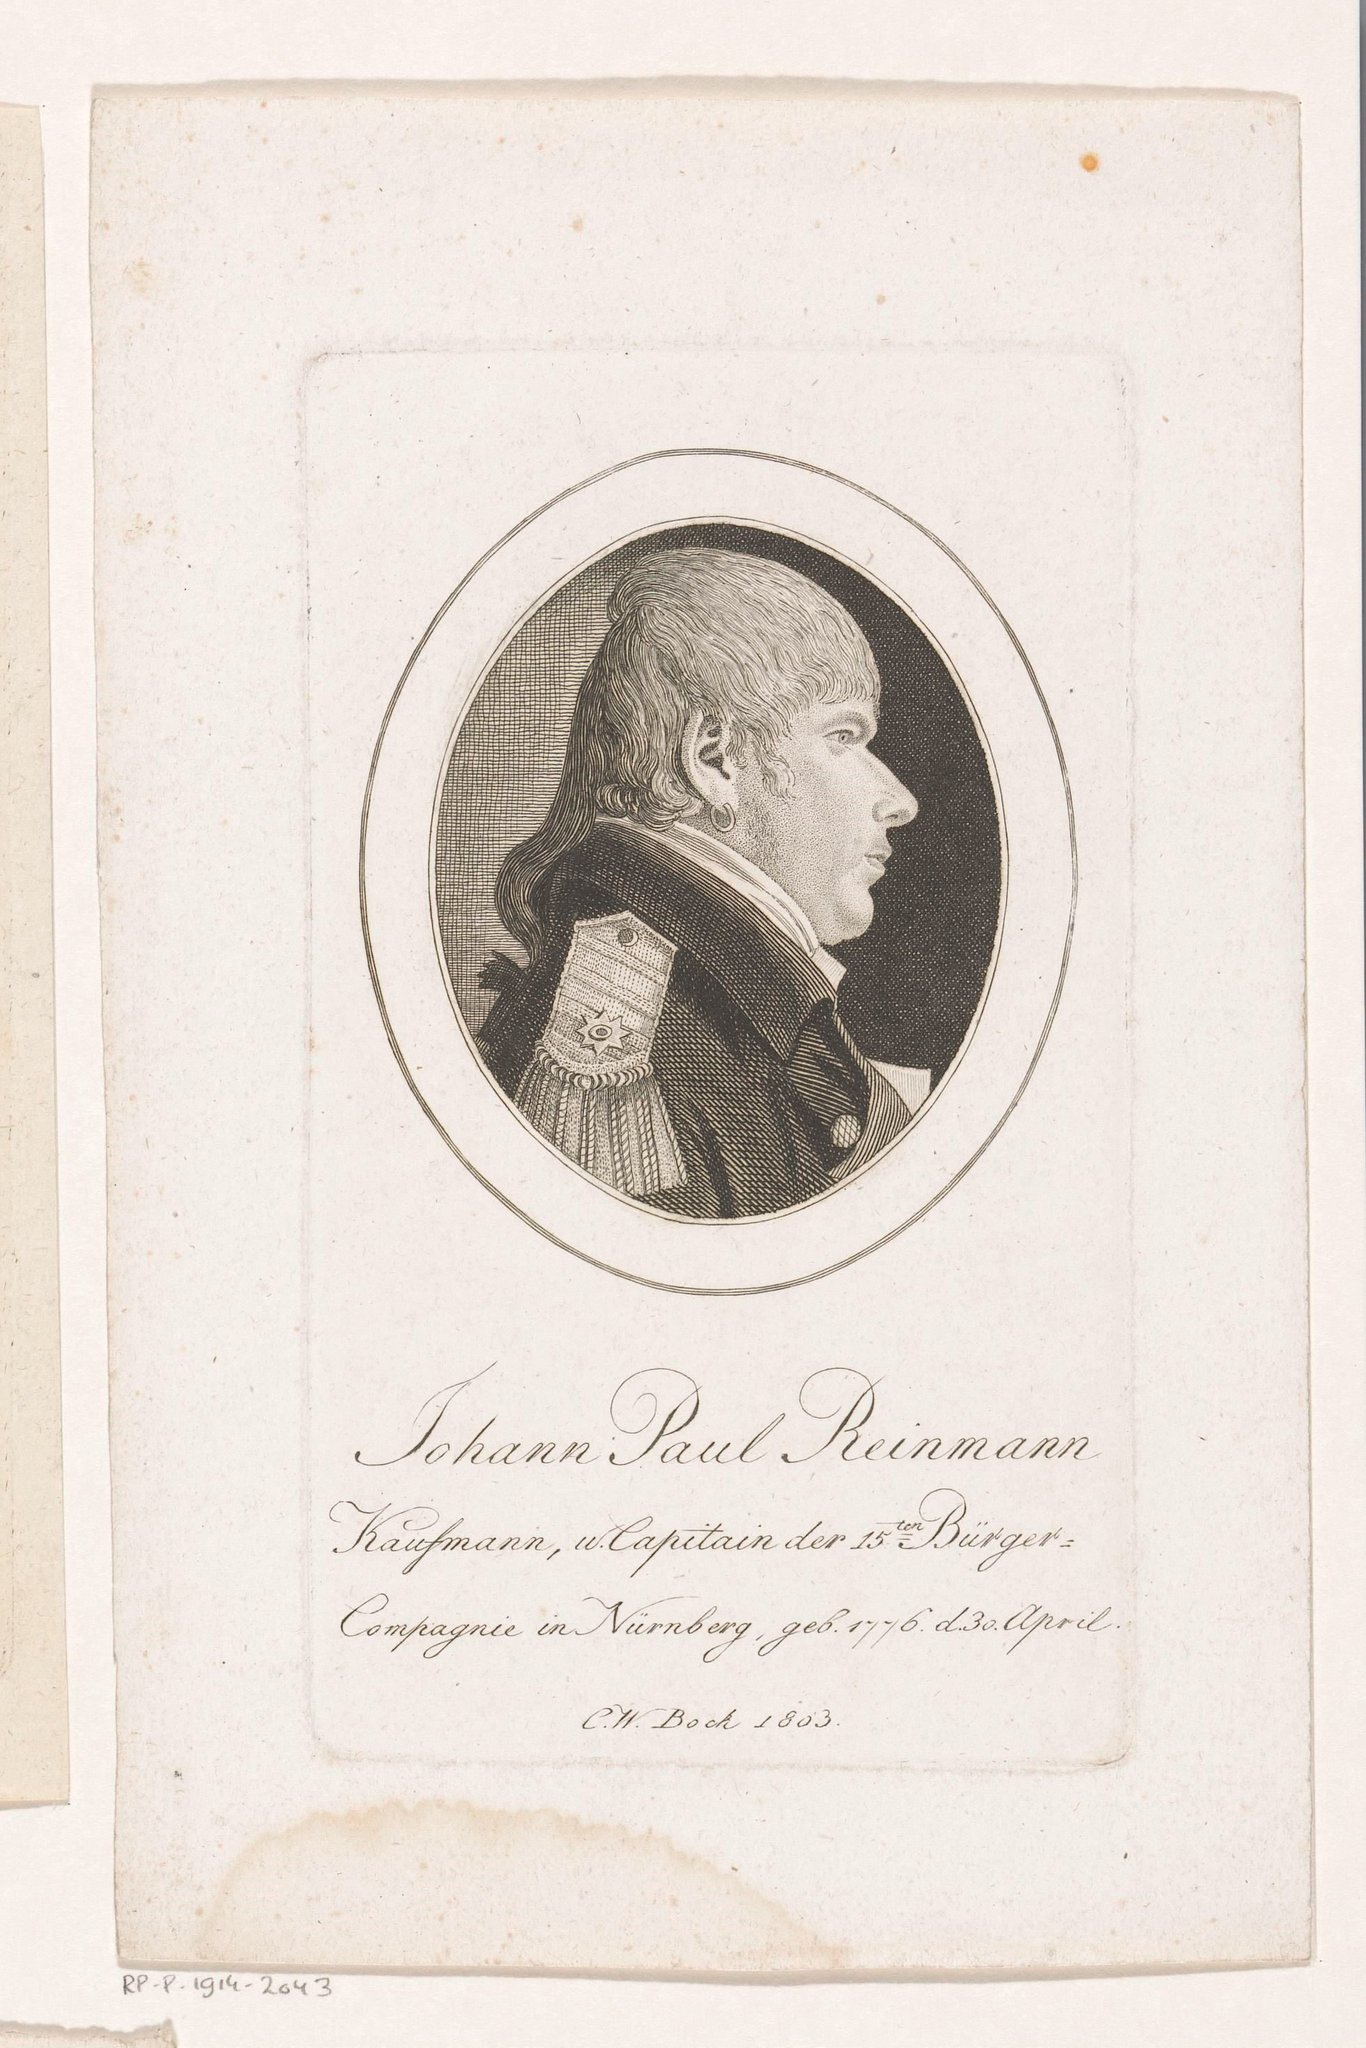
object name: print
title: Portret van Johann Paul Reinmann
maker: christoph wilhelm bock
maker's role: print maker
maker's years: 1755-1836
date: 1803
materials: paper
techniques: engraving, etching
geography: nuremberg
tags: historical persons, (military) uniforms, ear-rings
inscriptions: collector's mark: Lugt 2228